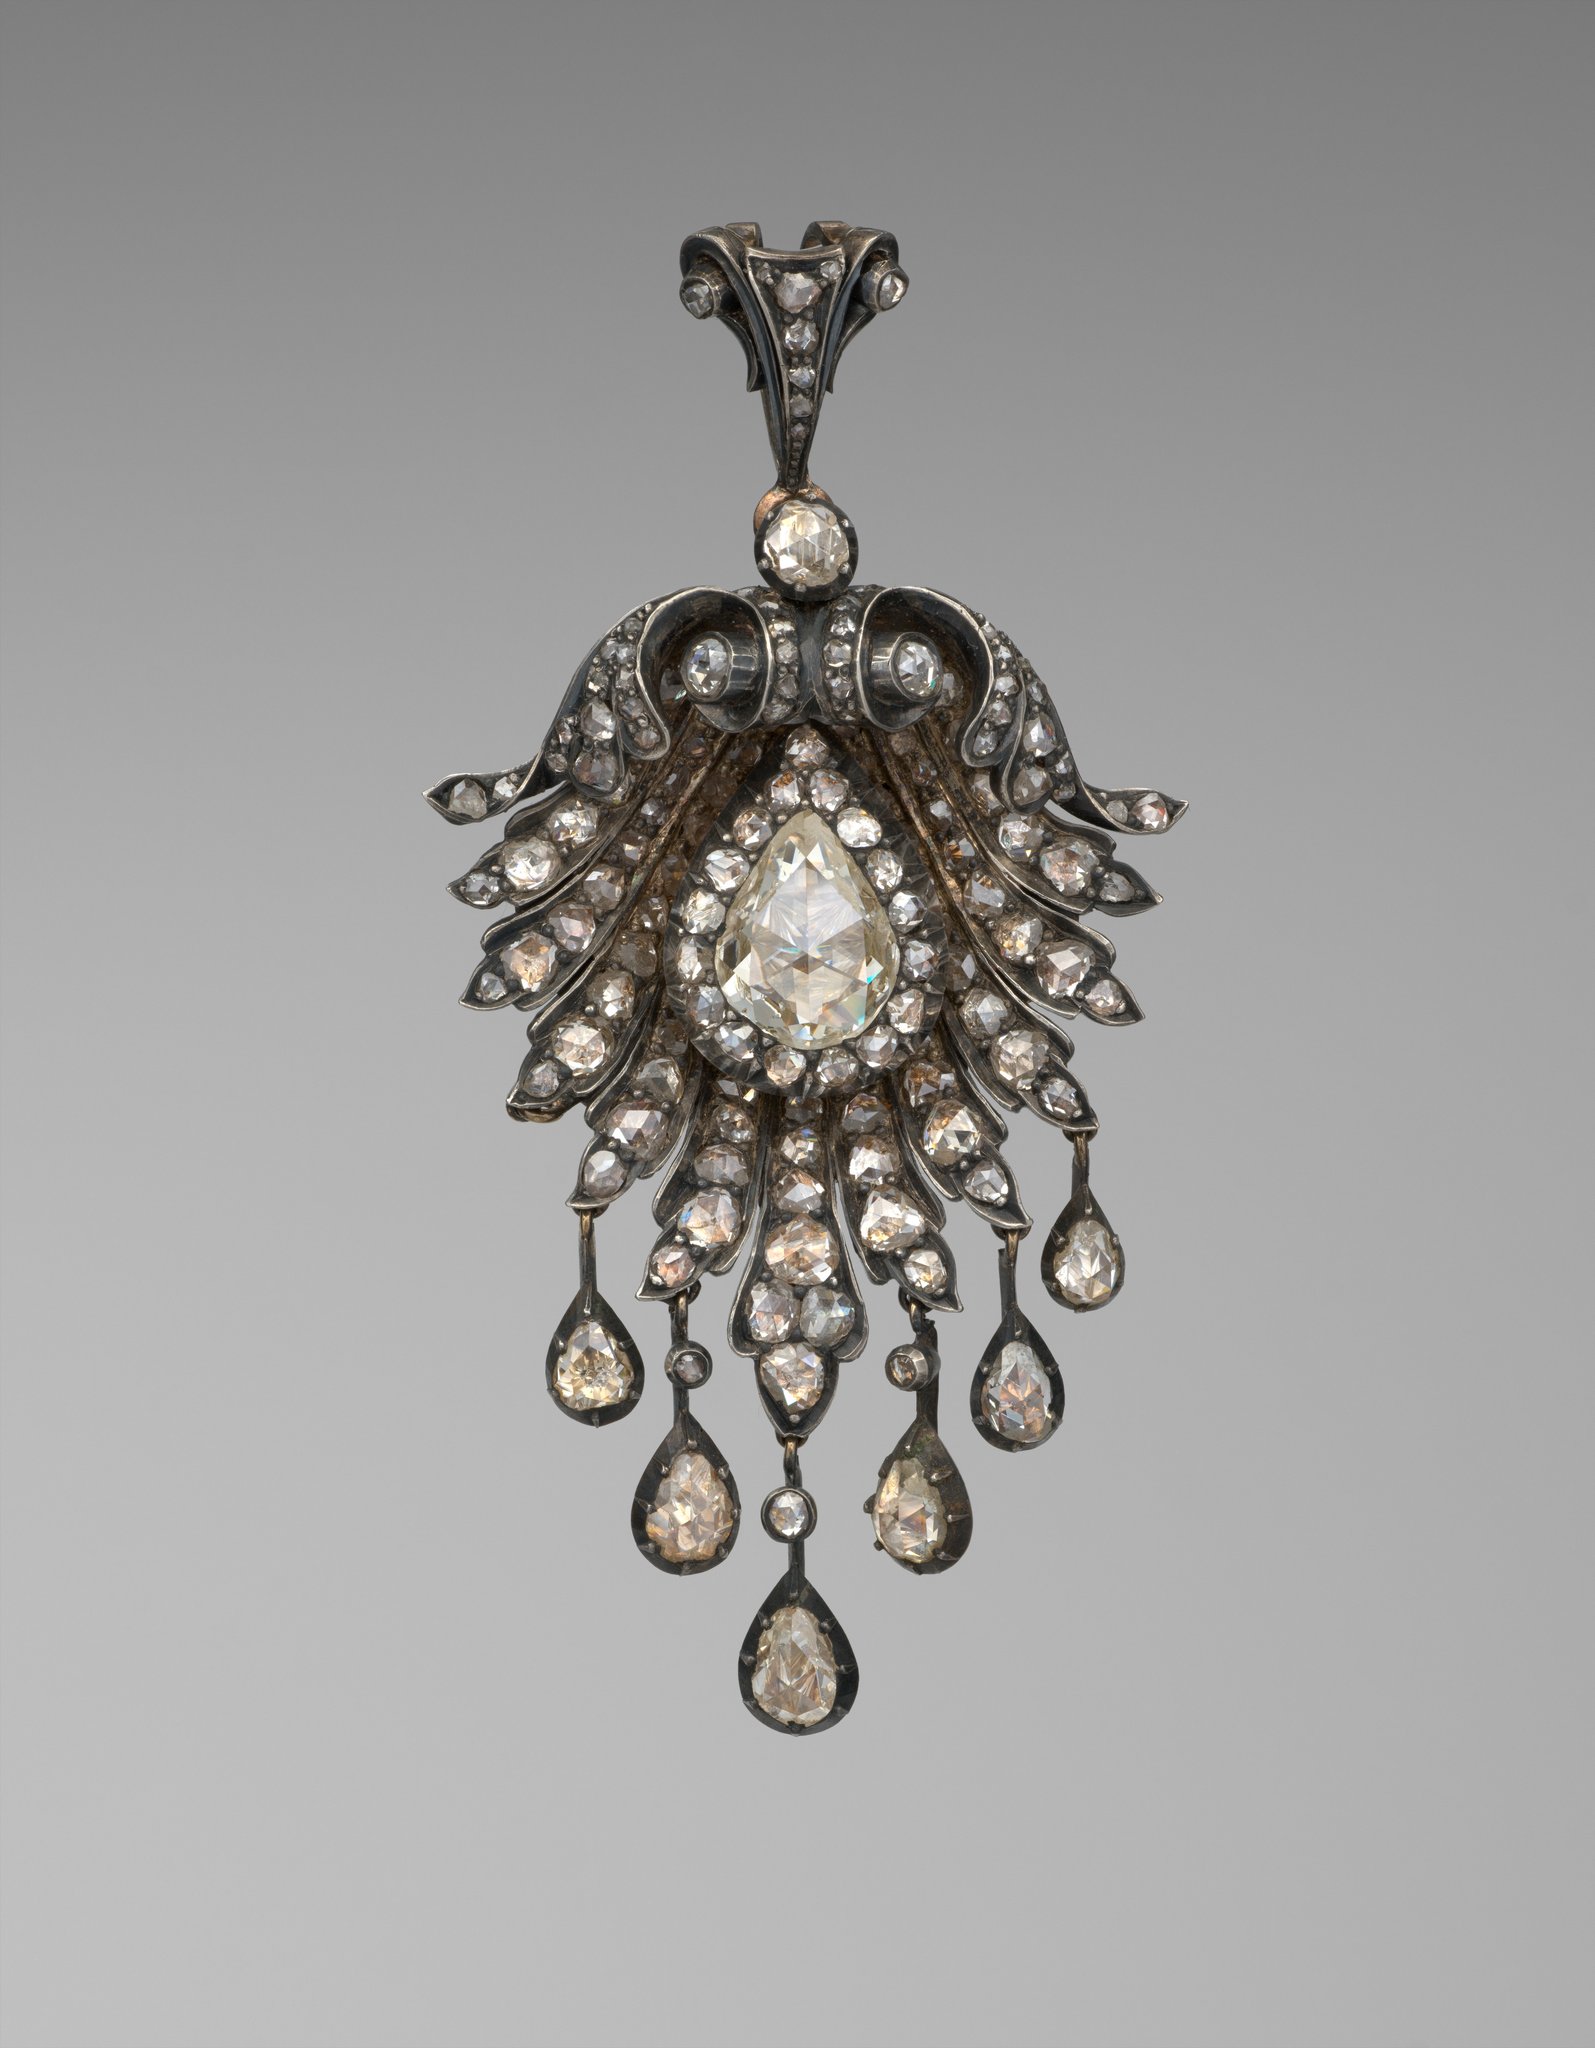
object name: brooch or pendant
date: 1801-1900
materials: diamond, gold, platinum